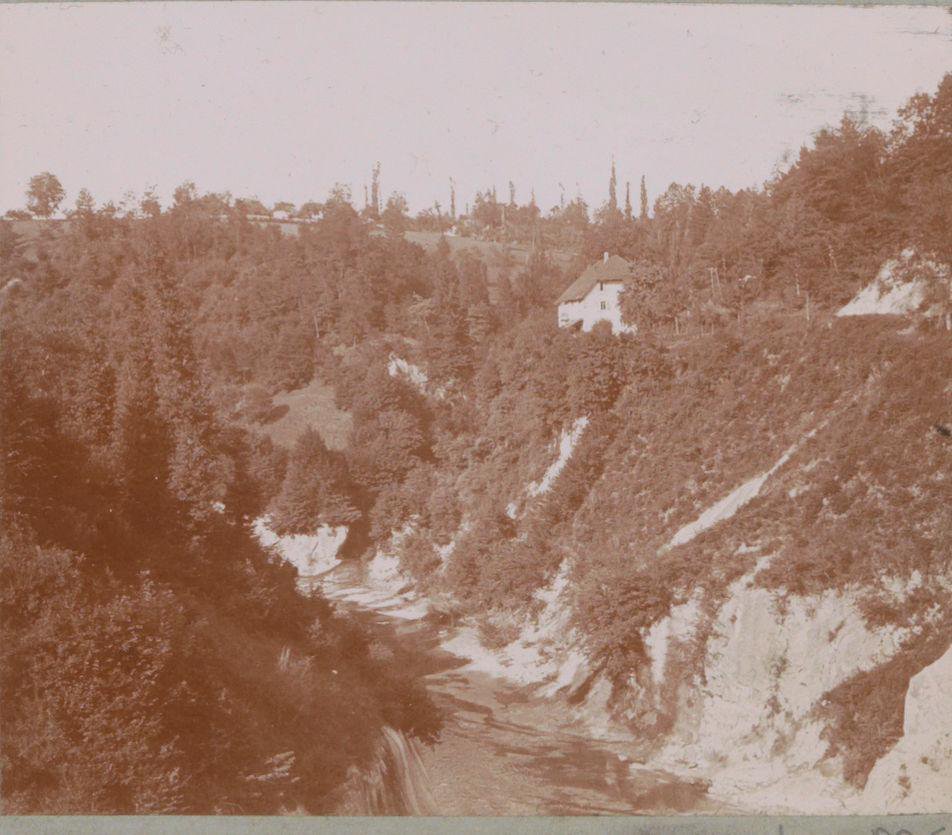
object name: photograph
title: Landschap met huizen aan een vermoedelijk een drooggevallen beekbedding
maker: Anonymous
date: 1905-1910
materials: paper, photographic support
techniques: gelatin silver print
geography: europe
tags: dry river, river bed, europe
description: Onderdeel van Fotoalbum van een Franse amateurfotograaf met bezienswaardigheden in Frankrijk, Zwitserland en Italië.